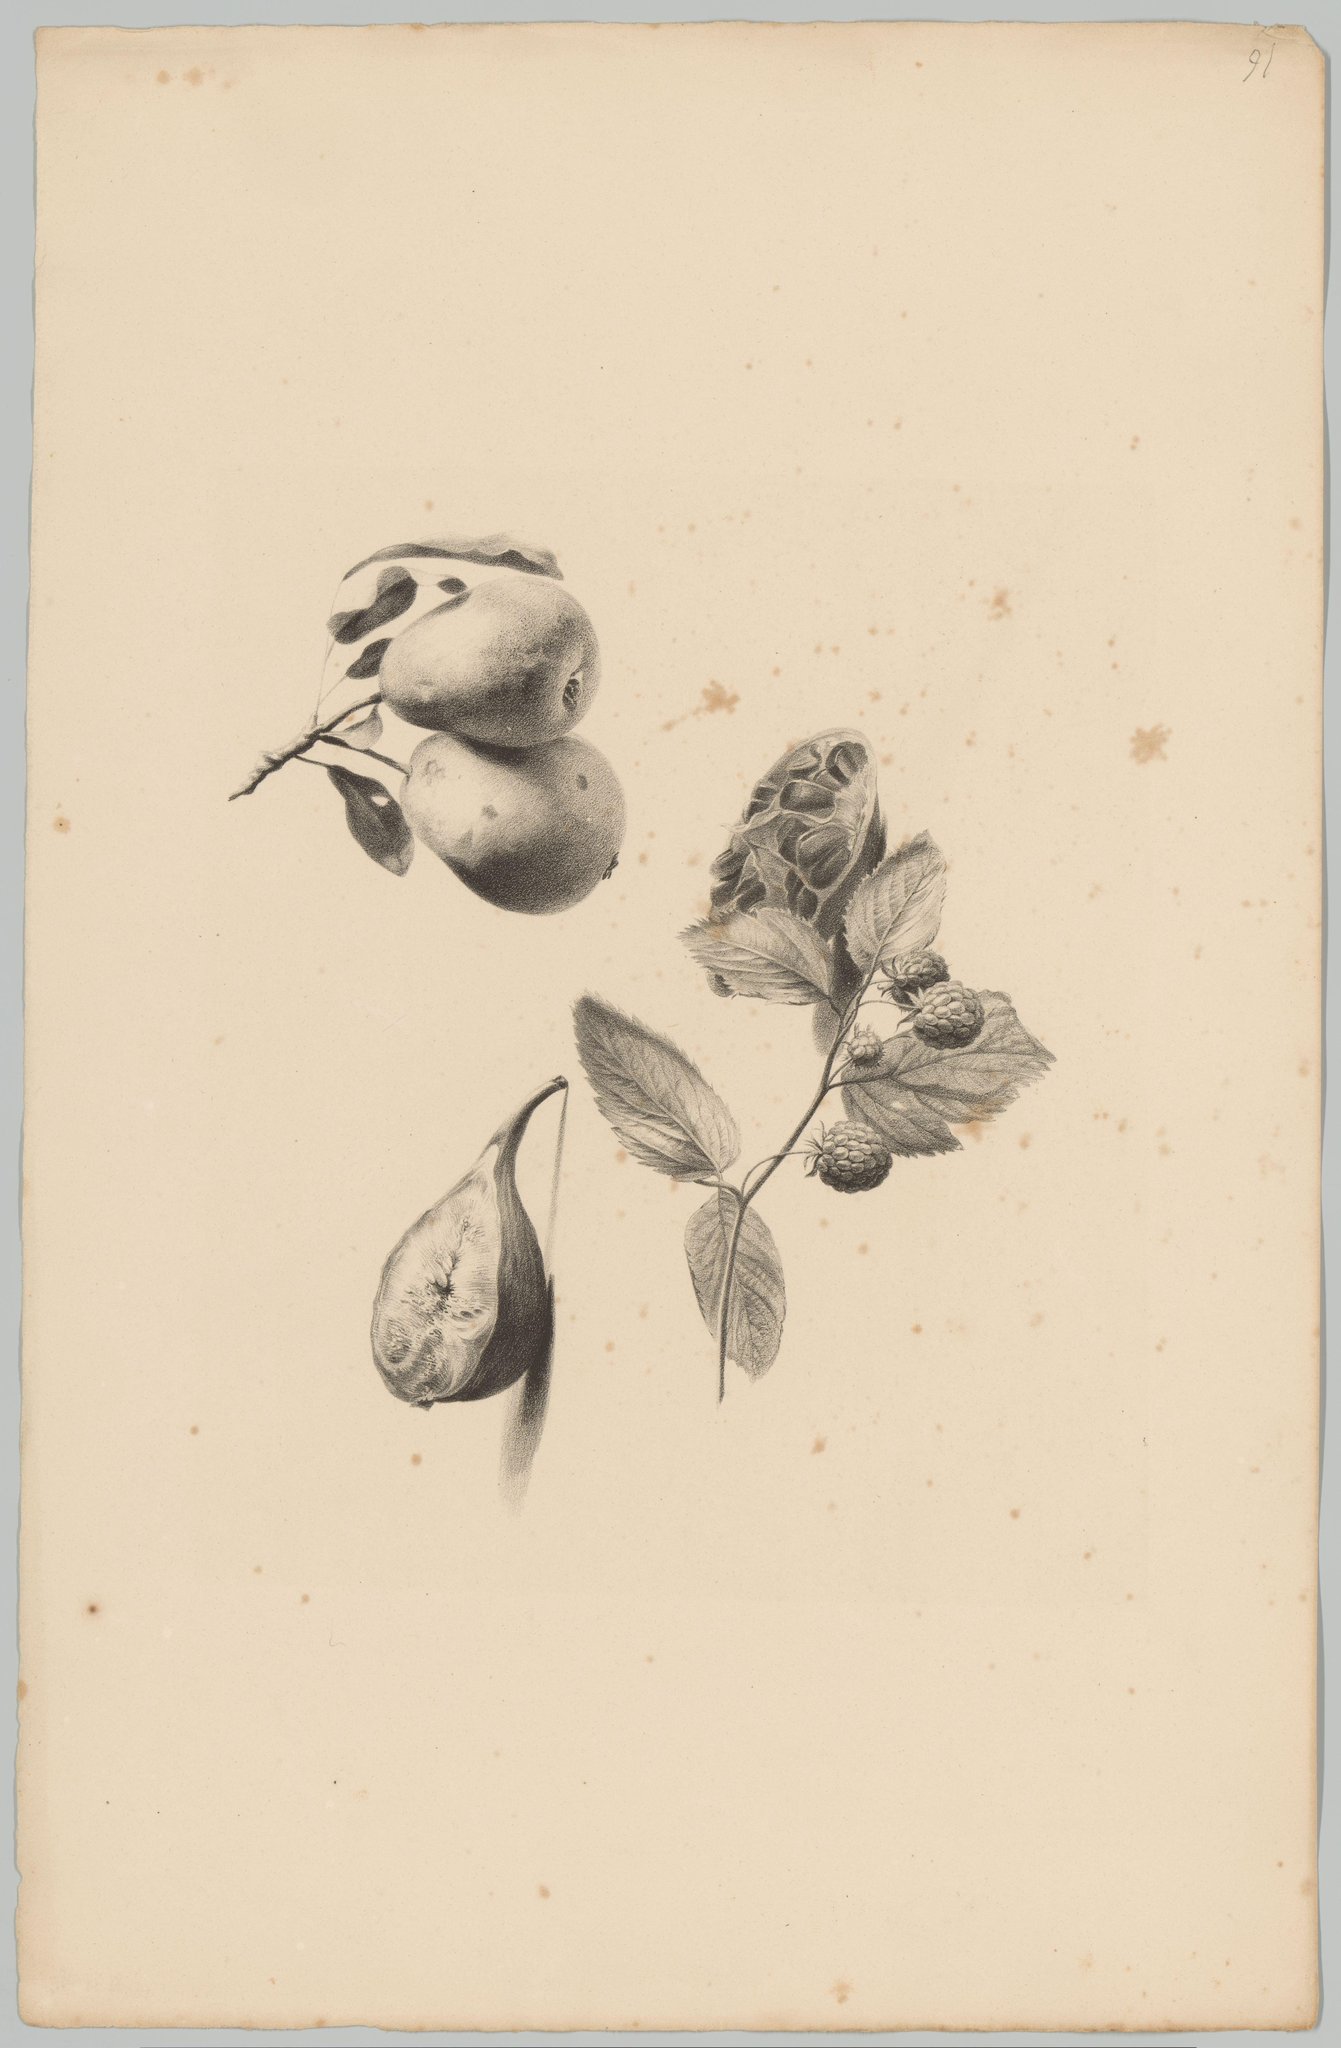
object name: print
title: Bloem en Fruit Studien (...) 3de aflevering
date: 1820-1833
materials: paper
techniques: lithograph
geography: amsterdam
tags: fruits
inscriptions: collector's mark: Lugt 2228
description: Onderdeel van een omslag met in totaal zevenenzeventig lithografieën van bloemen en fruit.